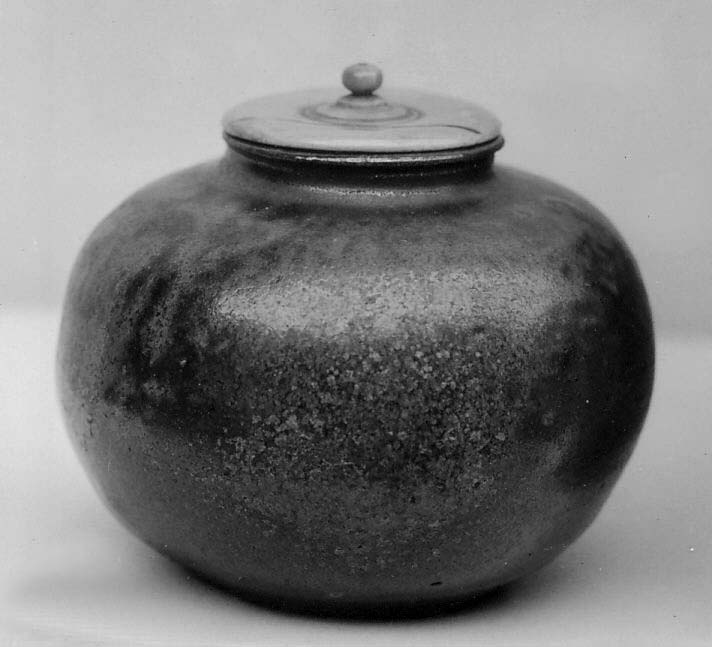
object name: tea jar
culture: japanese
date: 1775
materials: pottery